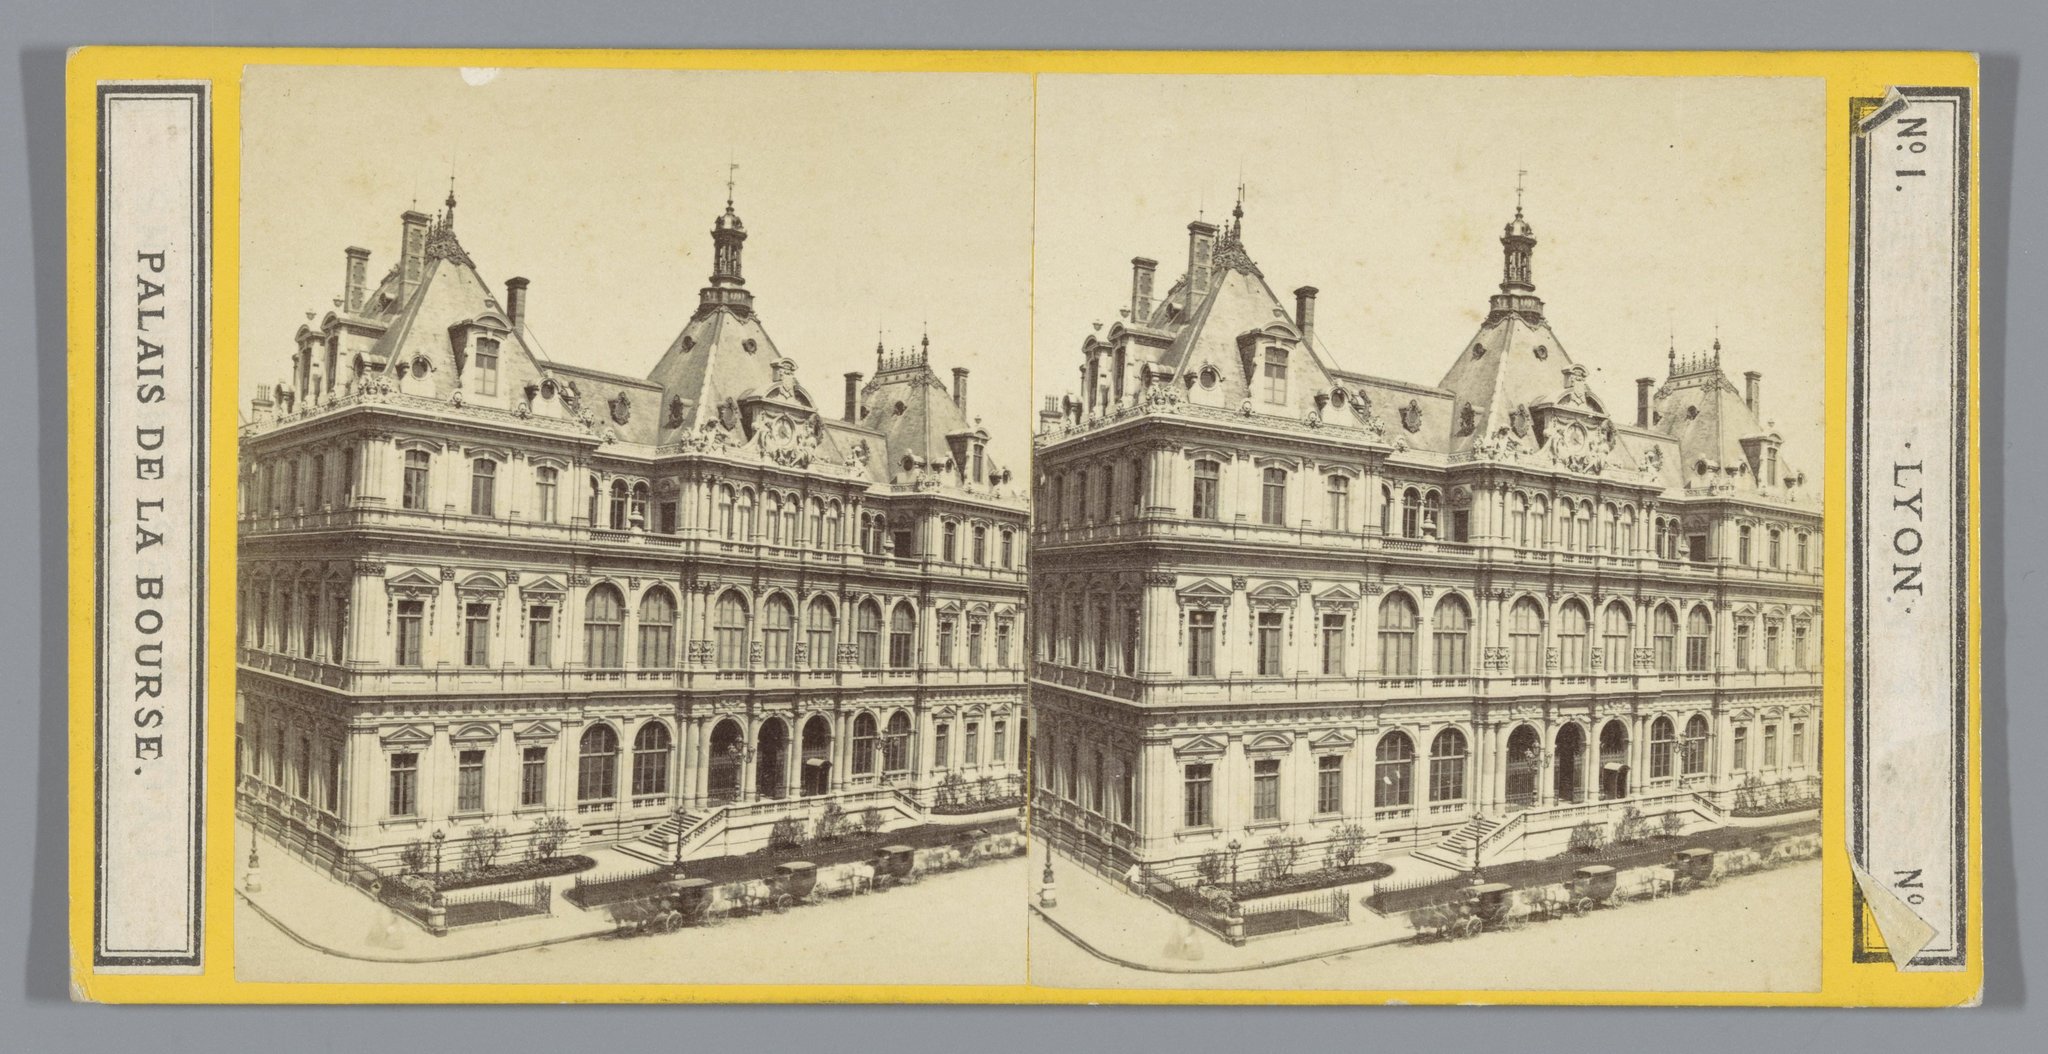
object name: stereograph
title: Exterieur van het Palais de la Bourse te Lyon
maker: Anonymous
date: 1860-1865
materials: cardboard, photographic support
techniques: albumen print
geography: lyon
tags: permanent exhibition, museum, façade (of house or building)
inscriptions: number: ‘No. 1.’, number: ‘1867. Juli No 15 Febr 1887’